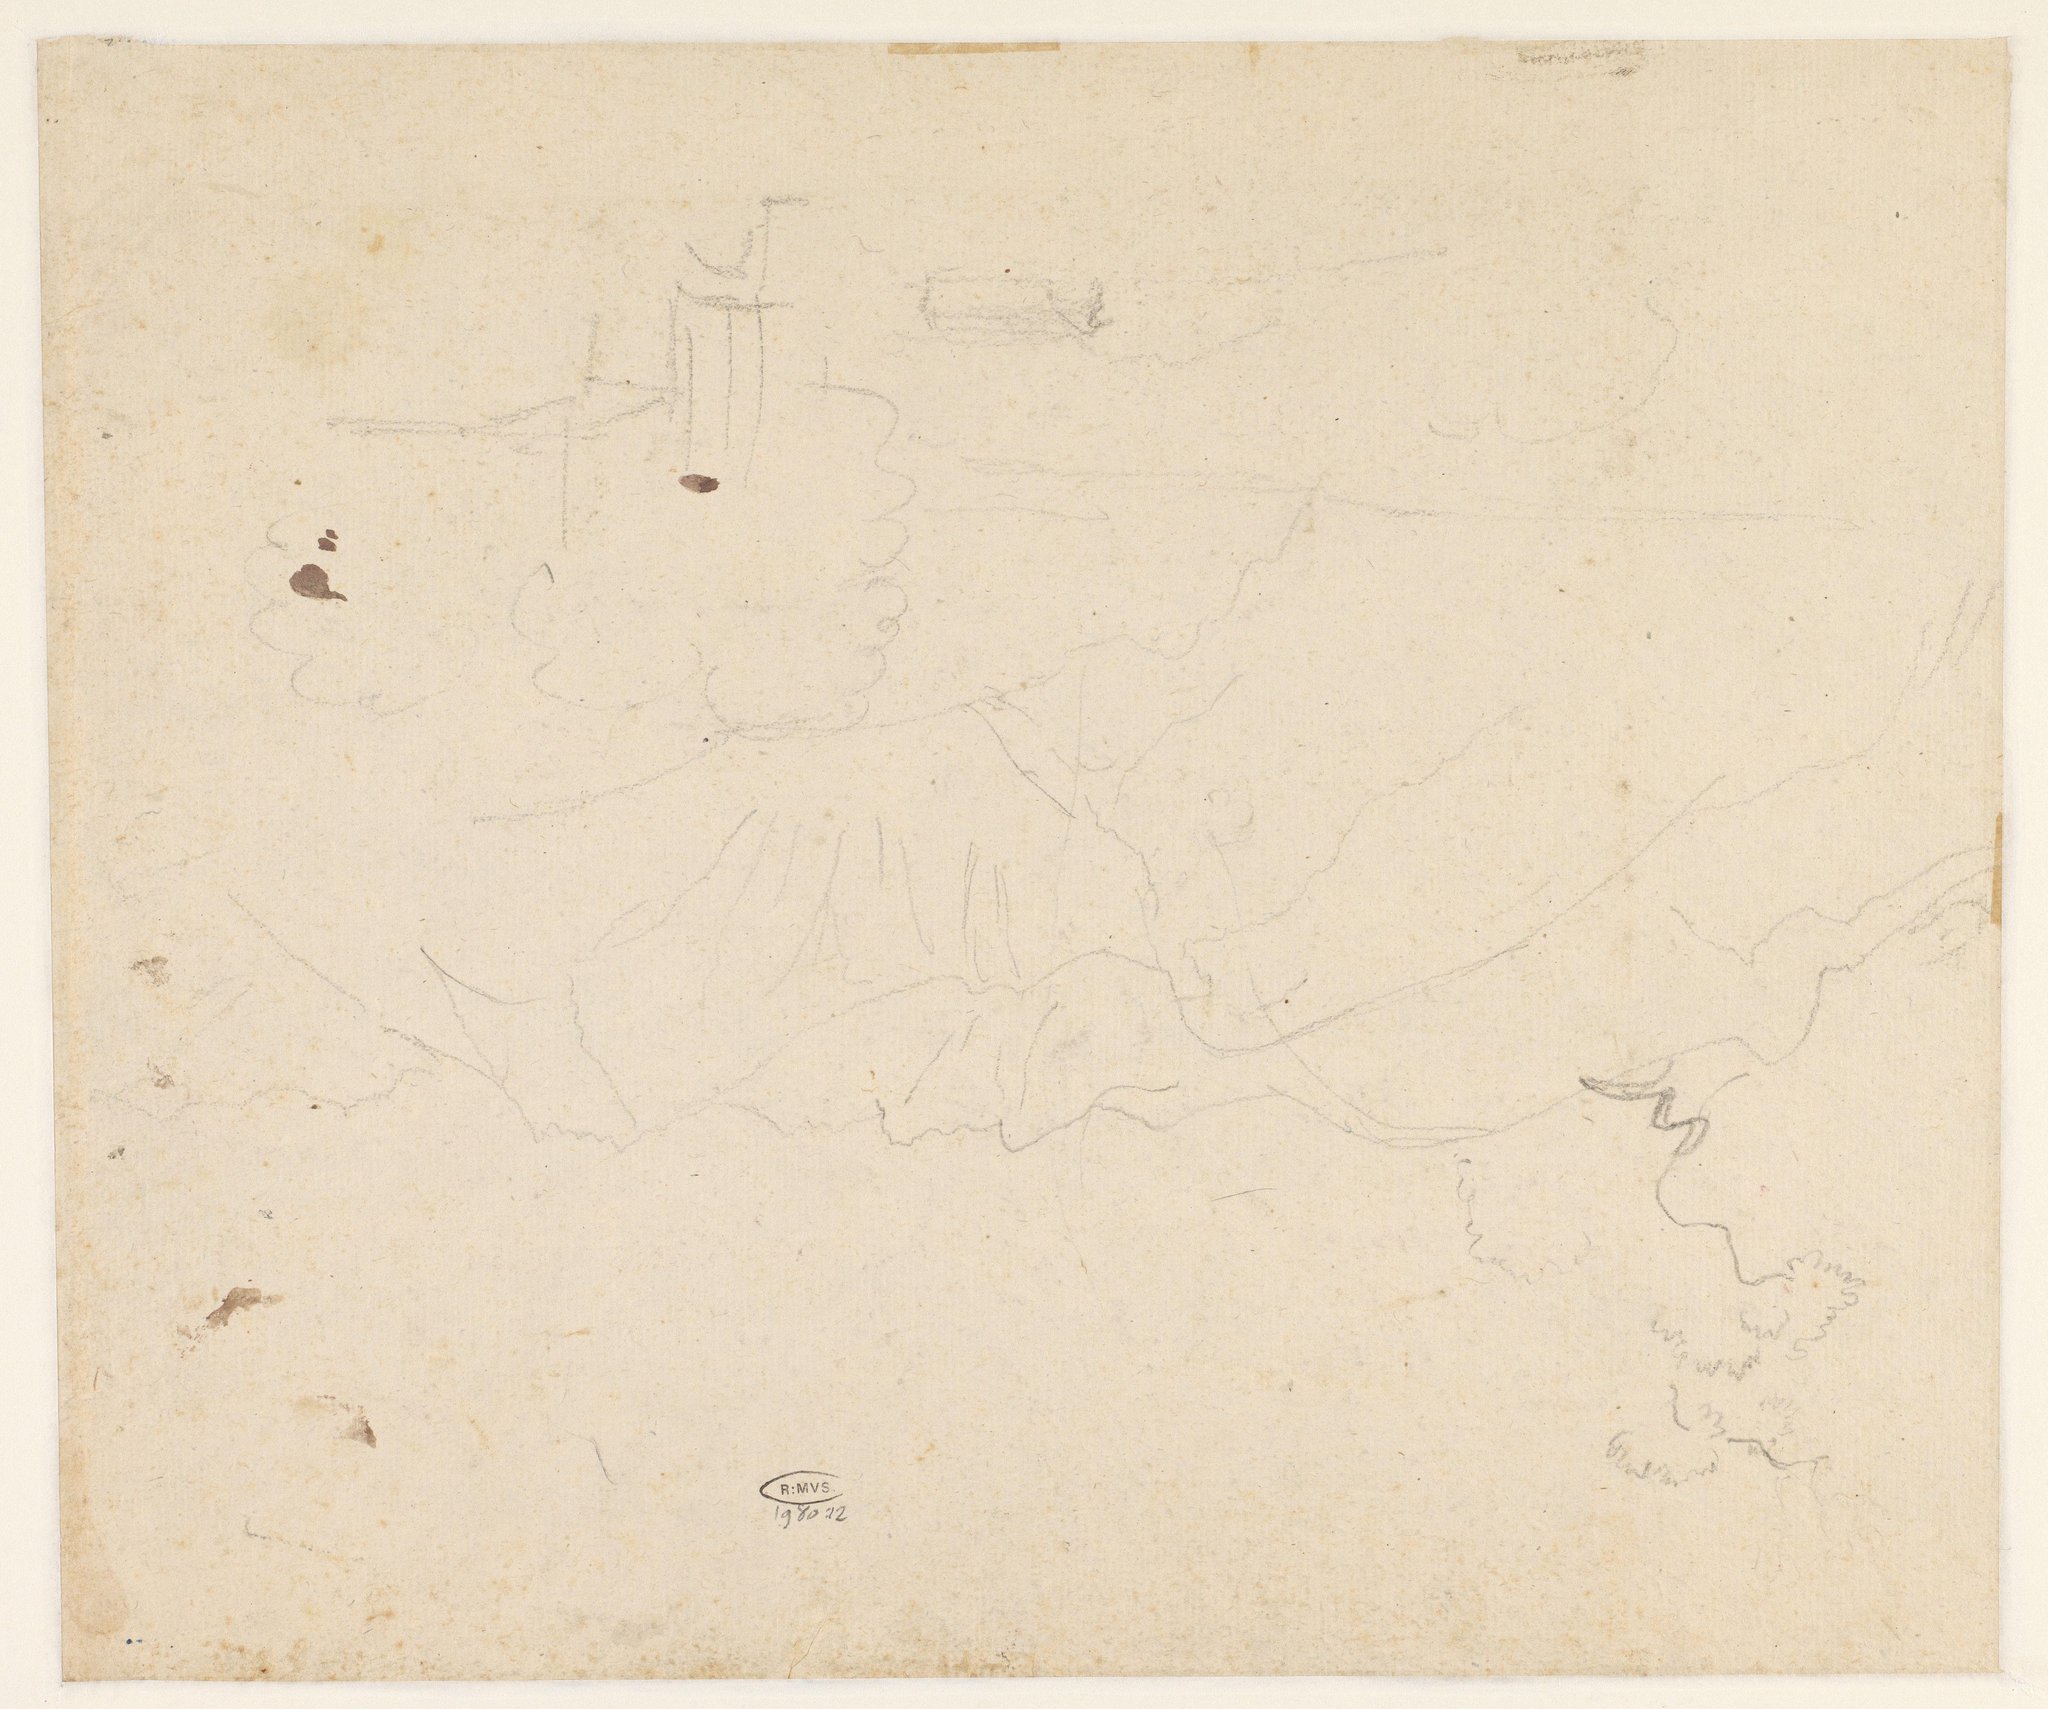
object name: drawing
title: Schets van een berglandschap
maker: henry swinburne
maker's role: draughtsman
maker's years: 1743-1803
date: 1753-1803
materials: chalk, paper